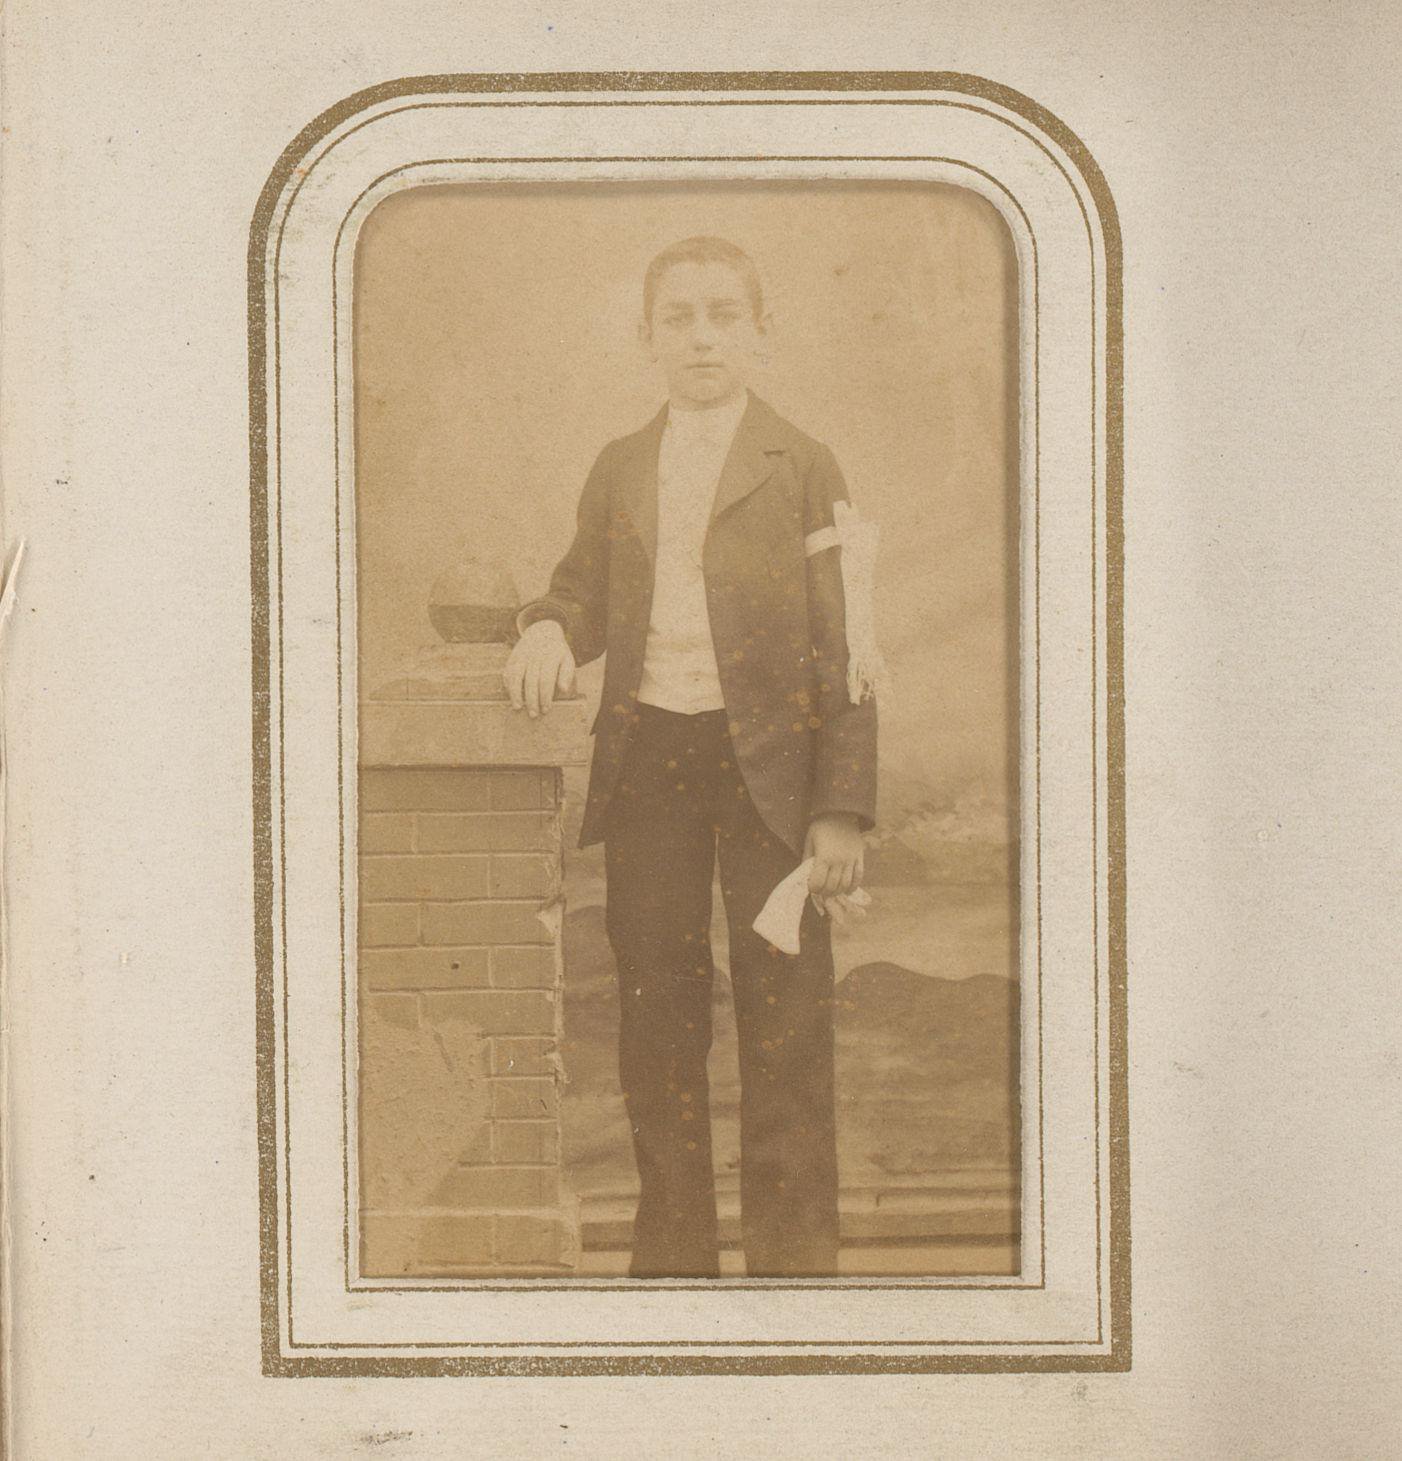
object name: album leaf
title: Portret van een jongen met een witte strik om de arm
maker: m. dunap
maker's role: fotograaf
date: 1880-1920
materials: cardboard, photographic support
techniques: albumen print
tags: communion dress, boy (child between toddler and youth), historical persons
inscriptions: inscription: ‘M. Dunap/ 1, Rue des Ecluses-St. Martin/ 47, Rue Grange-aux-Belles/ Paris/ Salon de Pose/ au rez-de-chausse’